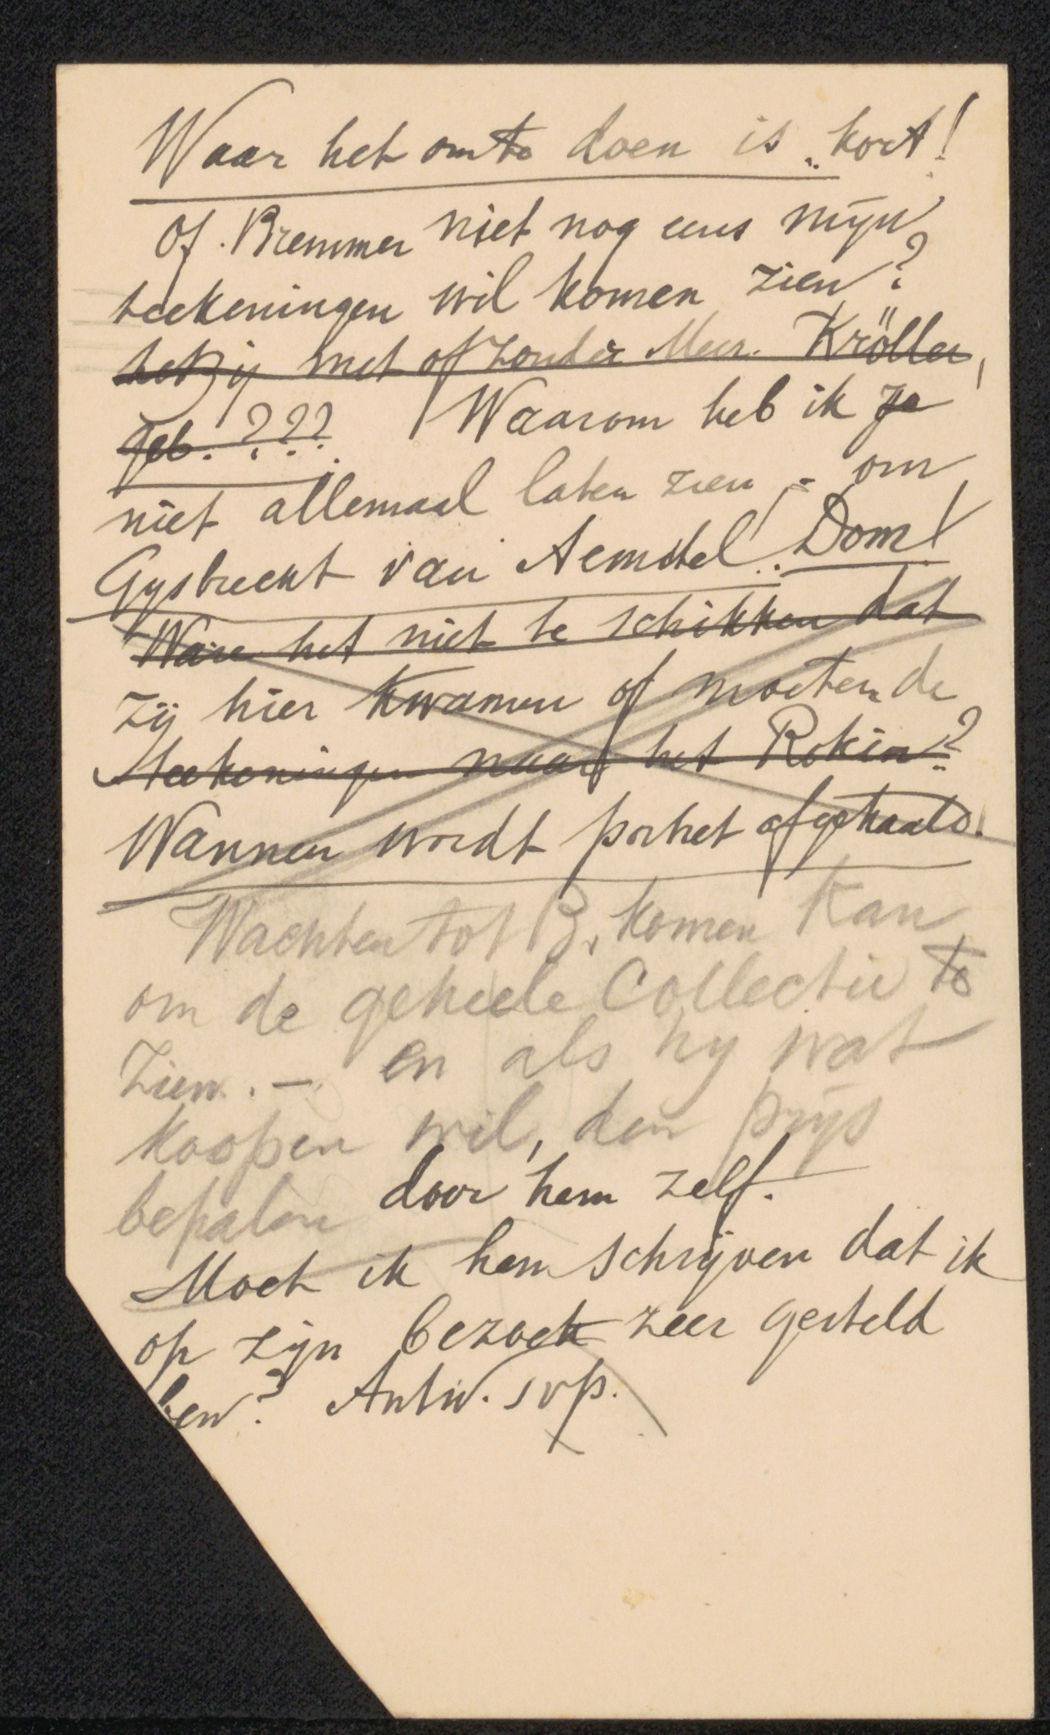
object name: letter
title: Brief aan anoniem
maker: august allebé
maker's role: draughtsman, print maker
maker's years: 1838-1927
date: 1848-1927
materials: cardboard, ink, pencil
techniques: pen, writing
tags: leiden, the hague, print maker, hendricus petrus bremmer, art trade, art shop, drawing